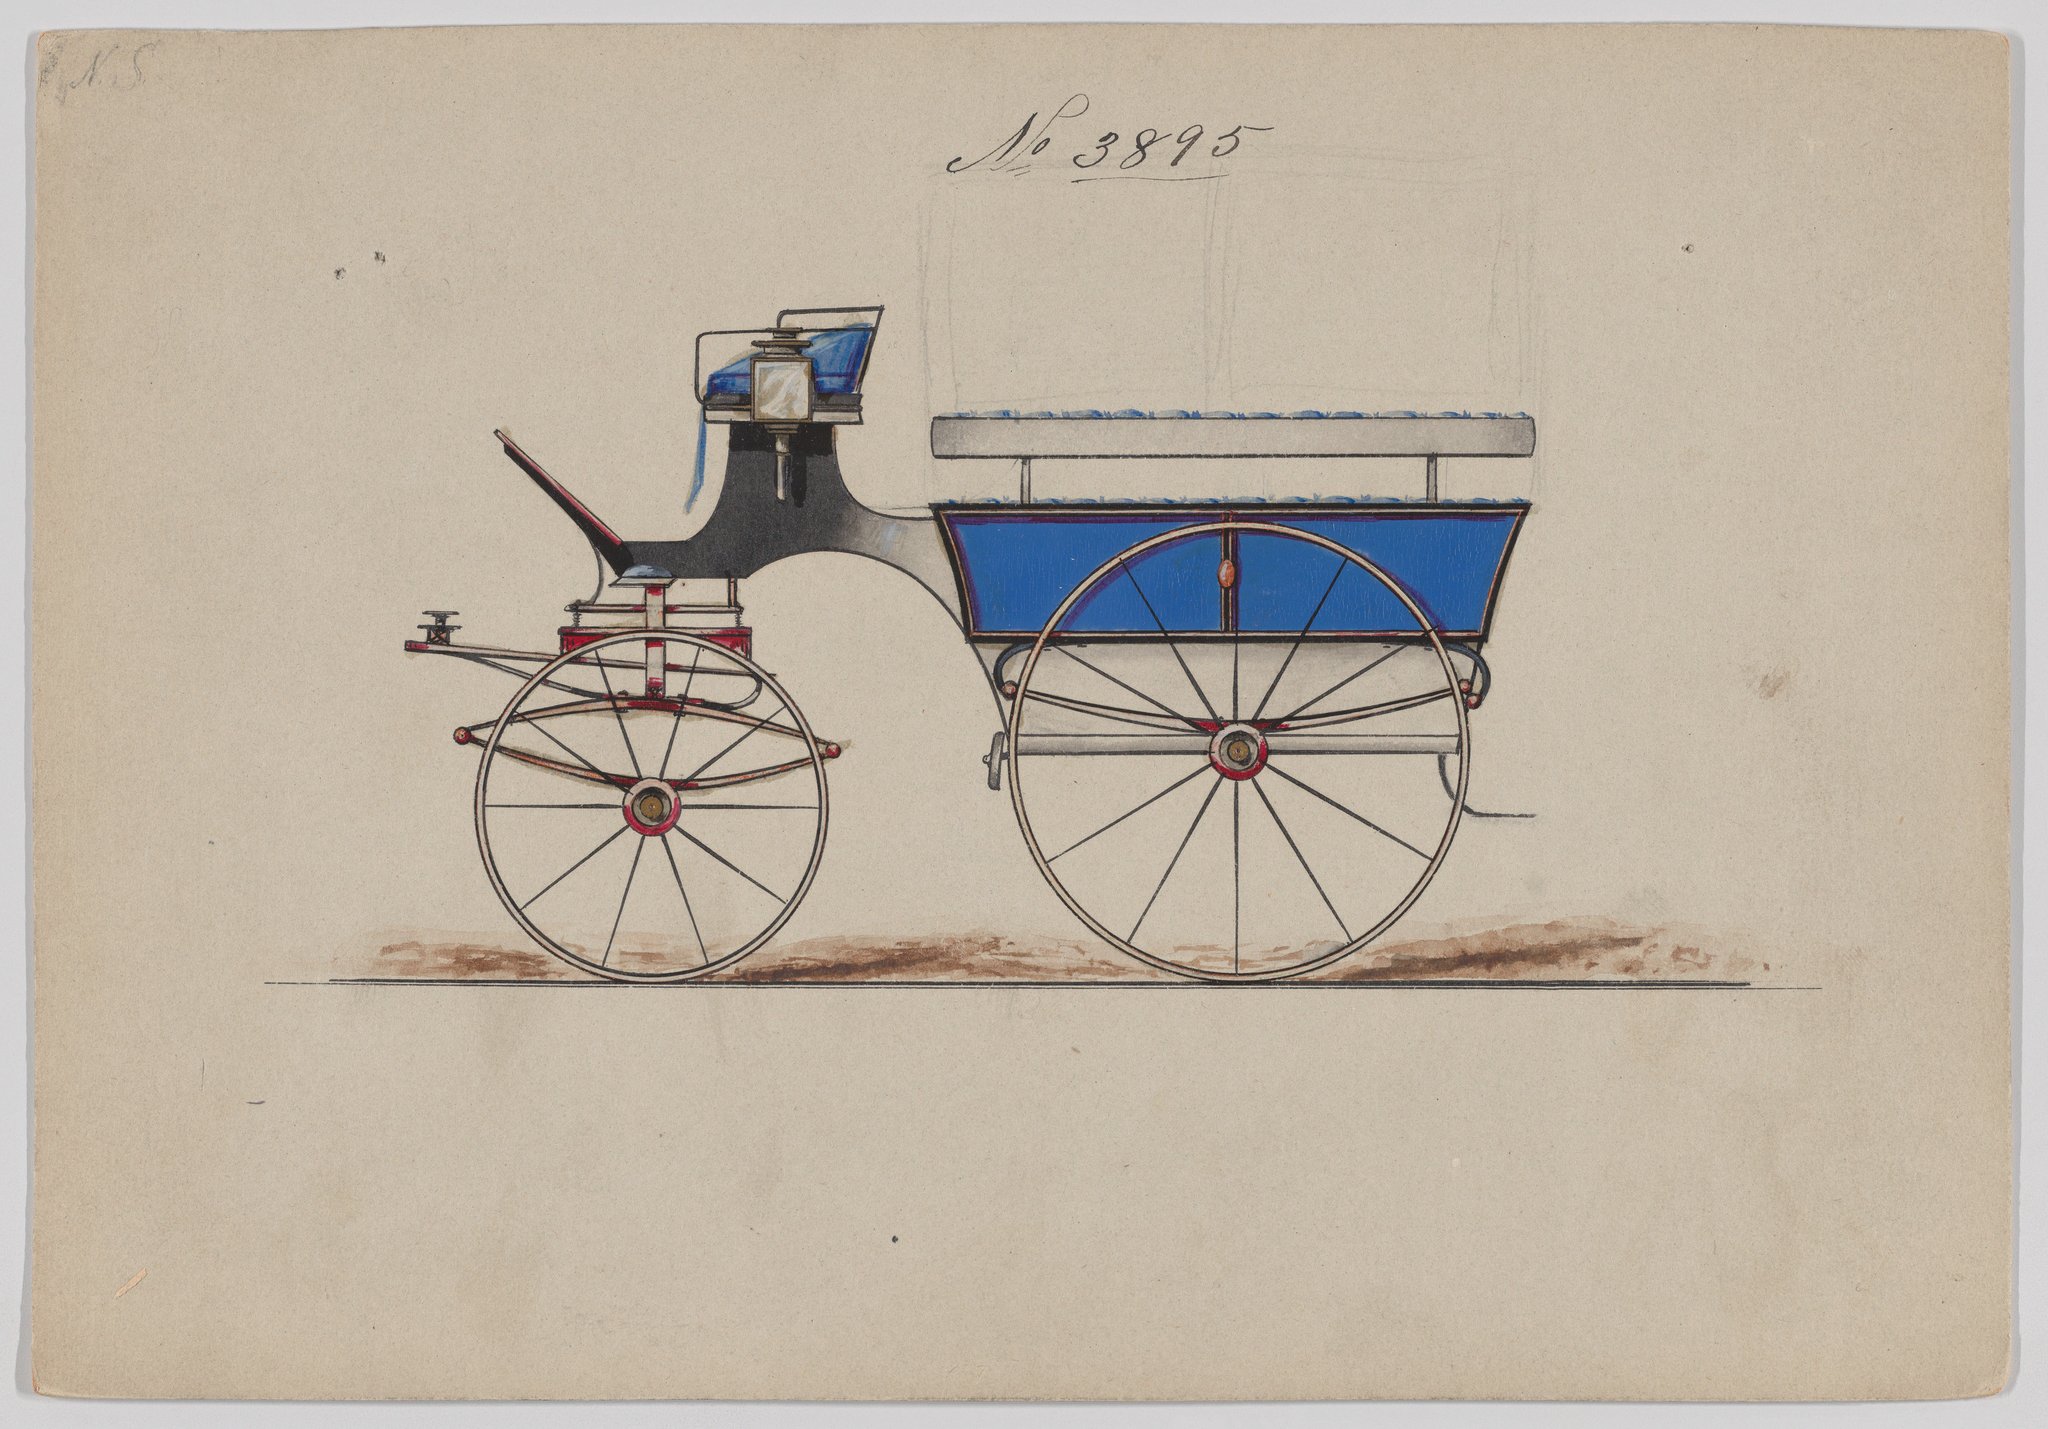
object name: drawing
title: Wagonette #3895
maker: brewster & co.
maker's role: manufacturer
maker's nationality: american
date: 1884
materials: gouache, graphite, gum arabic, ink, watercolor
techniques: pen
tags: carriages